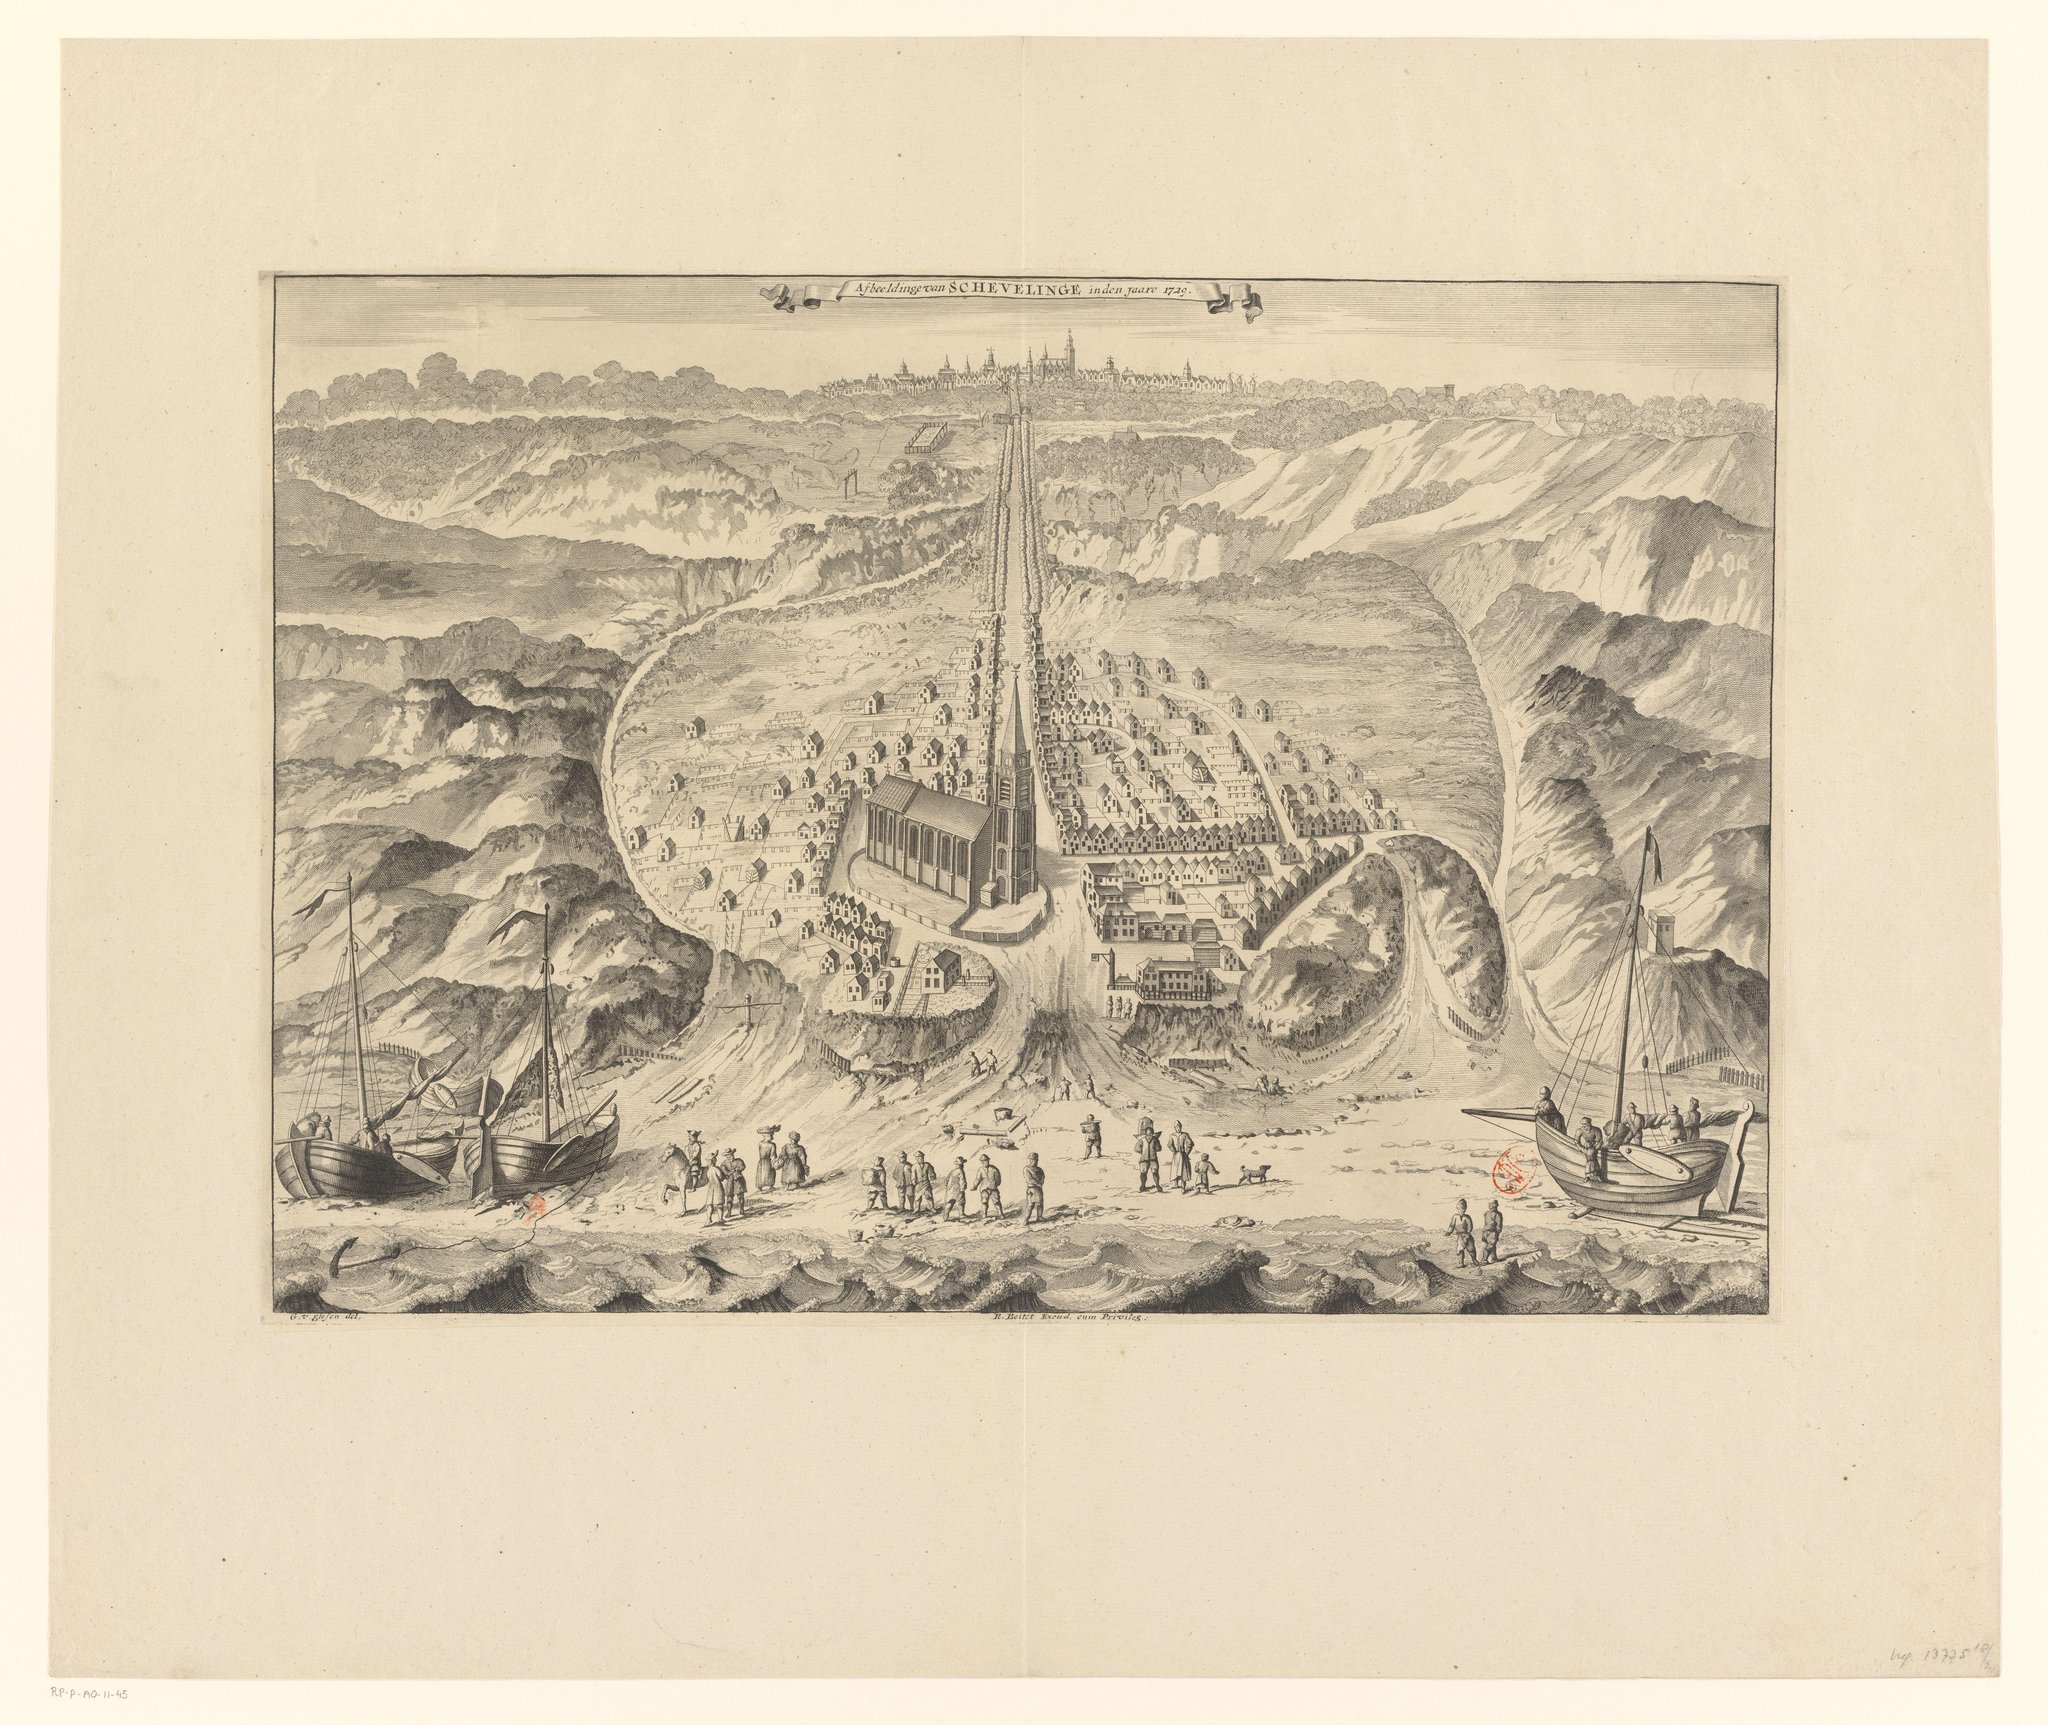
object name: print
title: Gezicht op Scheveningen, 1729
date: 1729-1736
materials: paper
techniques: engraving, etching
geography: the hague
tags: prospect of village, silhouette of village, sailing-ship, sailing-boat, church (exterior), prospect of city, town panorama, silhouette of city, beach (+ landscape with figures, staffage), sea, the hague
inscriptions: collector's mark: Lugt 195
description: Gezicht op het dorp Scheveningen in het jaar 1729. Op de voorgrond de zee en het strand met daarop een aantal figuren en schepen. Daarachter het dorp met in het midden de kerk. Op de achtergrond Den Haag. Boven een banderol met de titel.